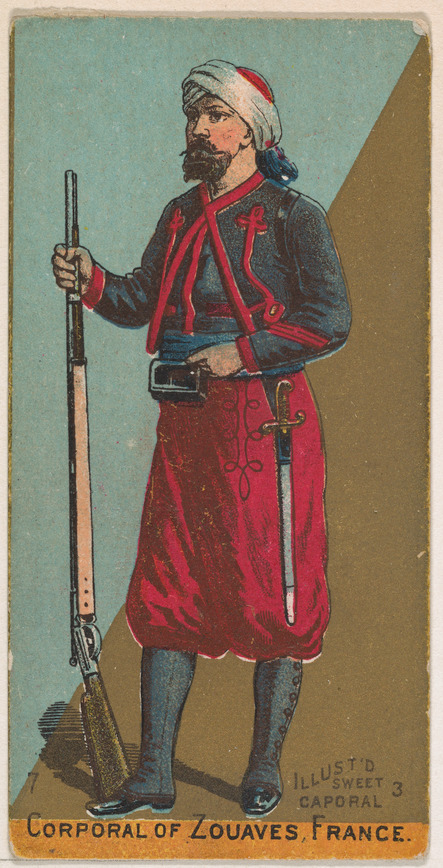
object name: print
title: Corporal of Zouaves, France, from the Military Series (N224) issued by Kinney Tobacco Company to promote Sweet Caporal Cigarettes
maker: kinney brothers tobacco company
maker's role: publisher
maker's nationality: american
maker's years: 1869-2011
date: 1888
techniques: color lithograph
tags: military,firearms,men